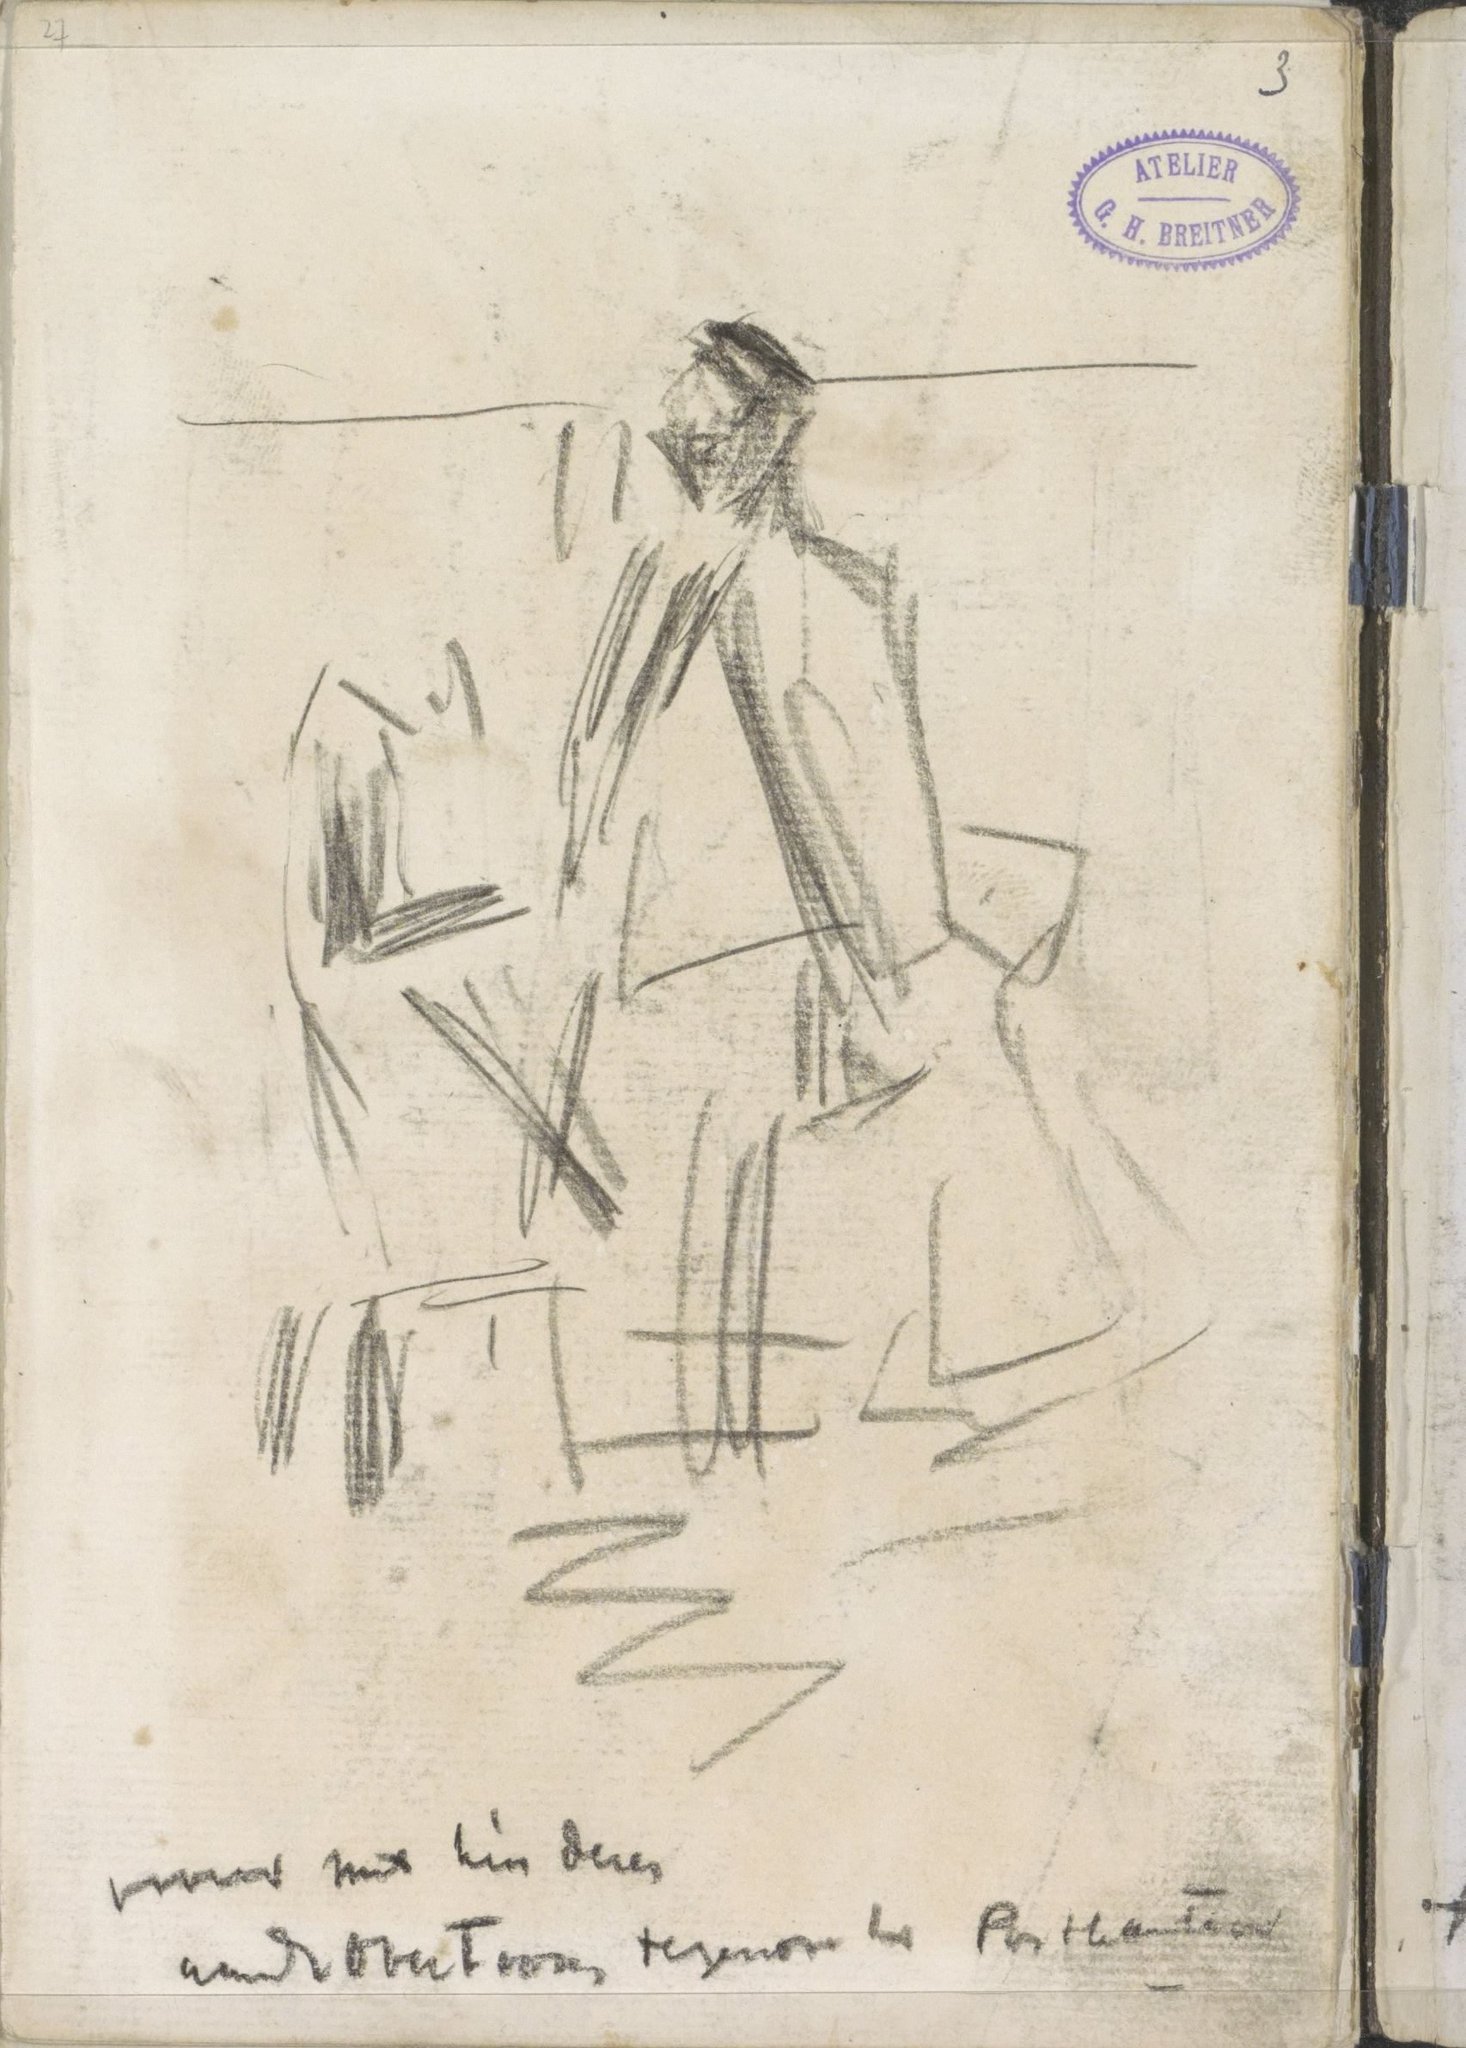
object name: sketchbook leaf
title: Vrouw met kinderen aan de Overtoom te Amsterdam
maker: george hendrik breitner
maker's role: draughtsman, painter, print maker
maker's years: 1857-1923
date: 1906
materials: chalk, paper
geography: amsterdam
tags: mother and child(ren), woman and child(ren) (family group)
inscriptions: workshop stamp: Lugt 291d, annotation: ‘vrouw met kinderen/ aan de Overtoom tegenover het postkantoor’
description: Pagina 27 uit een schetsboek met 14 bladen.